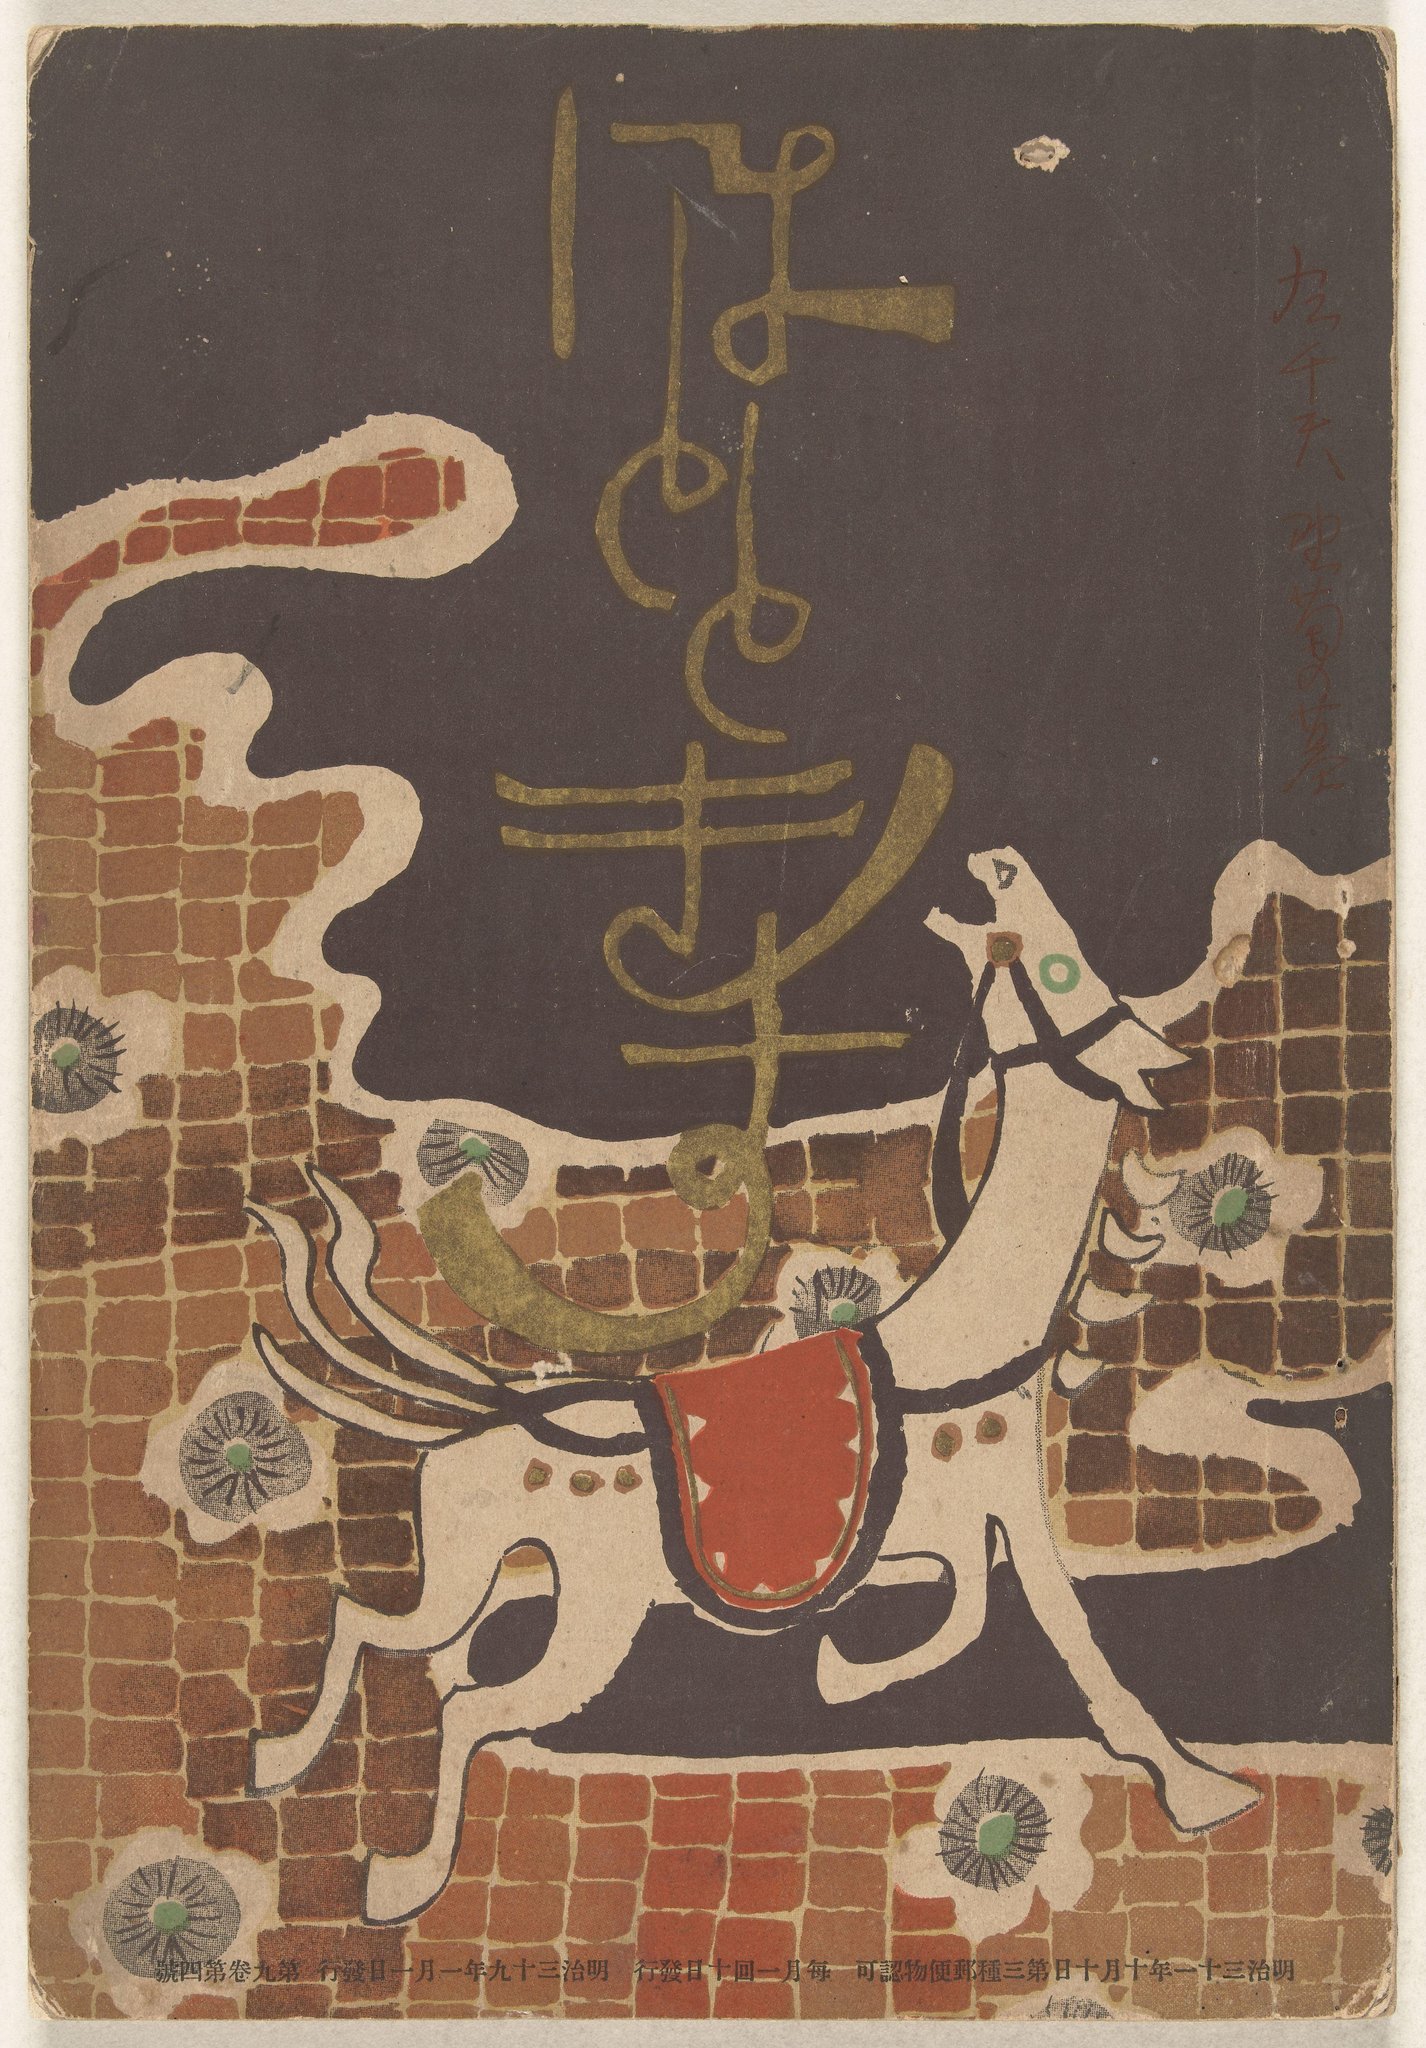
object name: magazine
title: Kleine koekoek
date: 1906-1907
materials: paper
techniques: woodcut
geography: japan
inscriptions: date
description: Alle uitgaven uit het jaar 1906 (12 exemplaren) van het literaire maandblad Hototogisu en drie exemplaren van de maanden april, juli en september uit 1907. Veel verschillende schrijvers en kunstenaars hebben aan dit tijdschrijft meegewerkt.